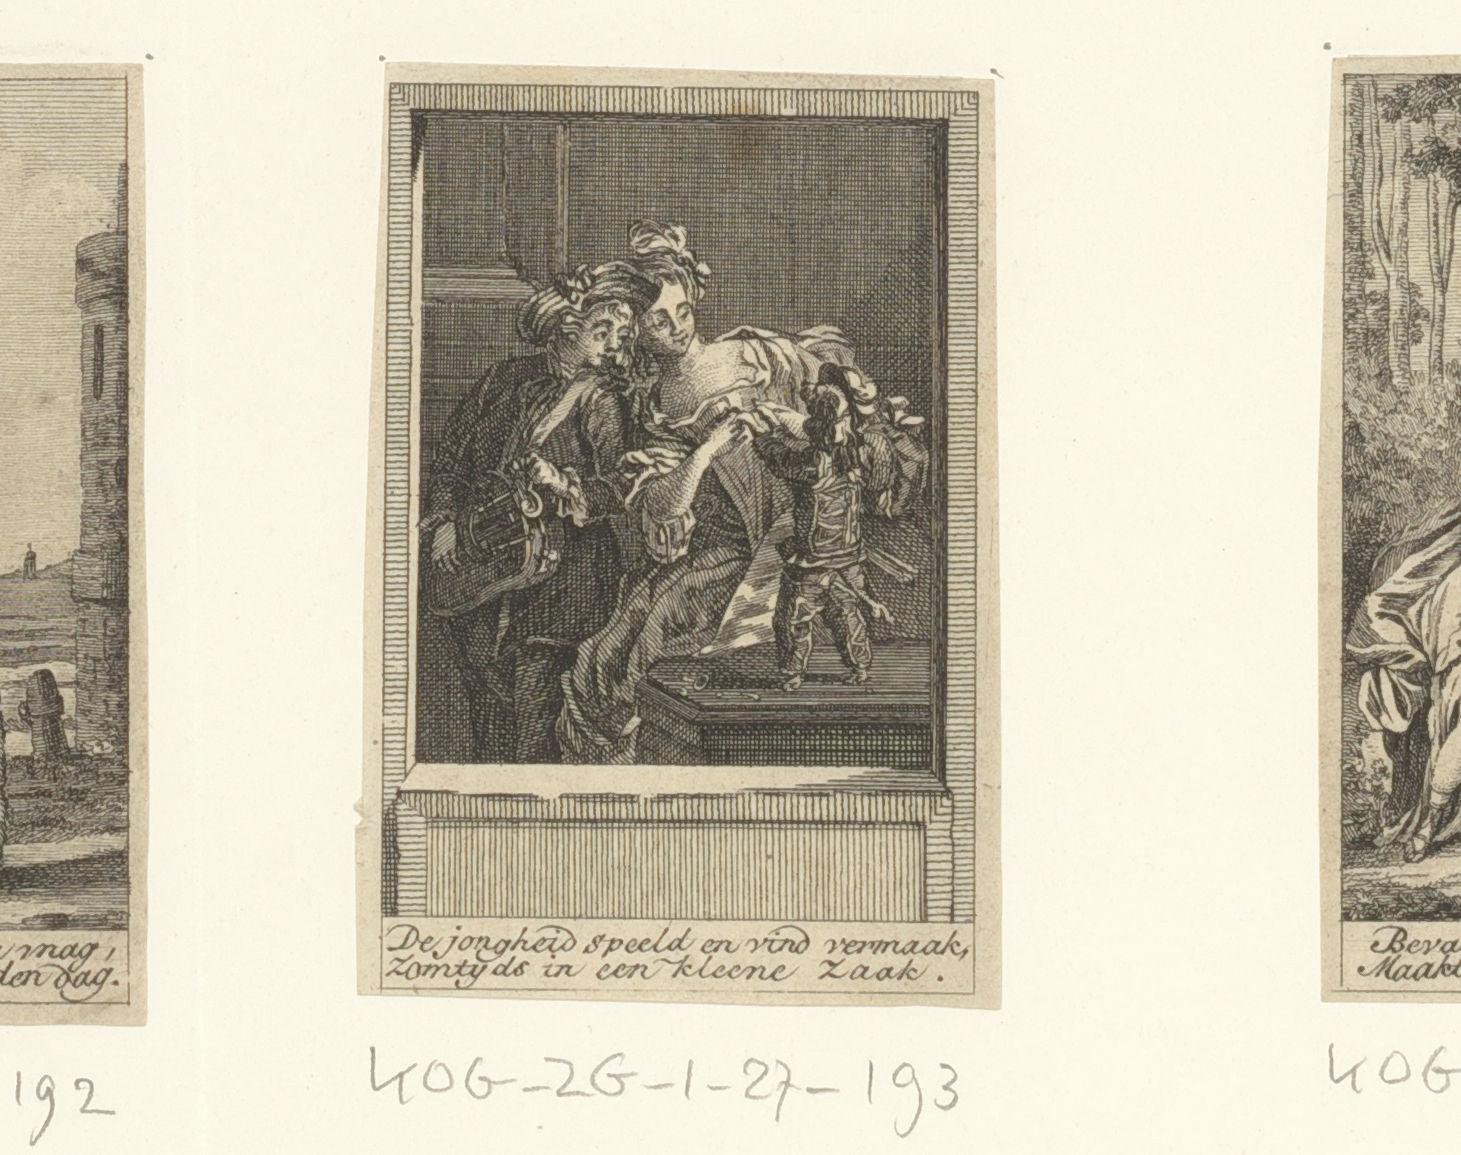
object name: print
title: Vrouw en liereman met een pop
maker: Anonymous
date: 1725-1799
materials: paper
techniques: engraving, etching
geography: netherlands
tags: dolls for adults, hurdy-gurdy player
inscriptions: collector's mark, collector's mark: Lugt 1641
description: Gebruikt als illustratie in een onbekende almanak.